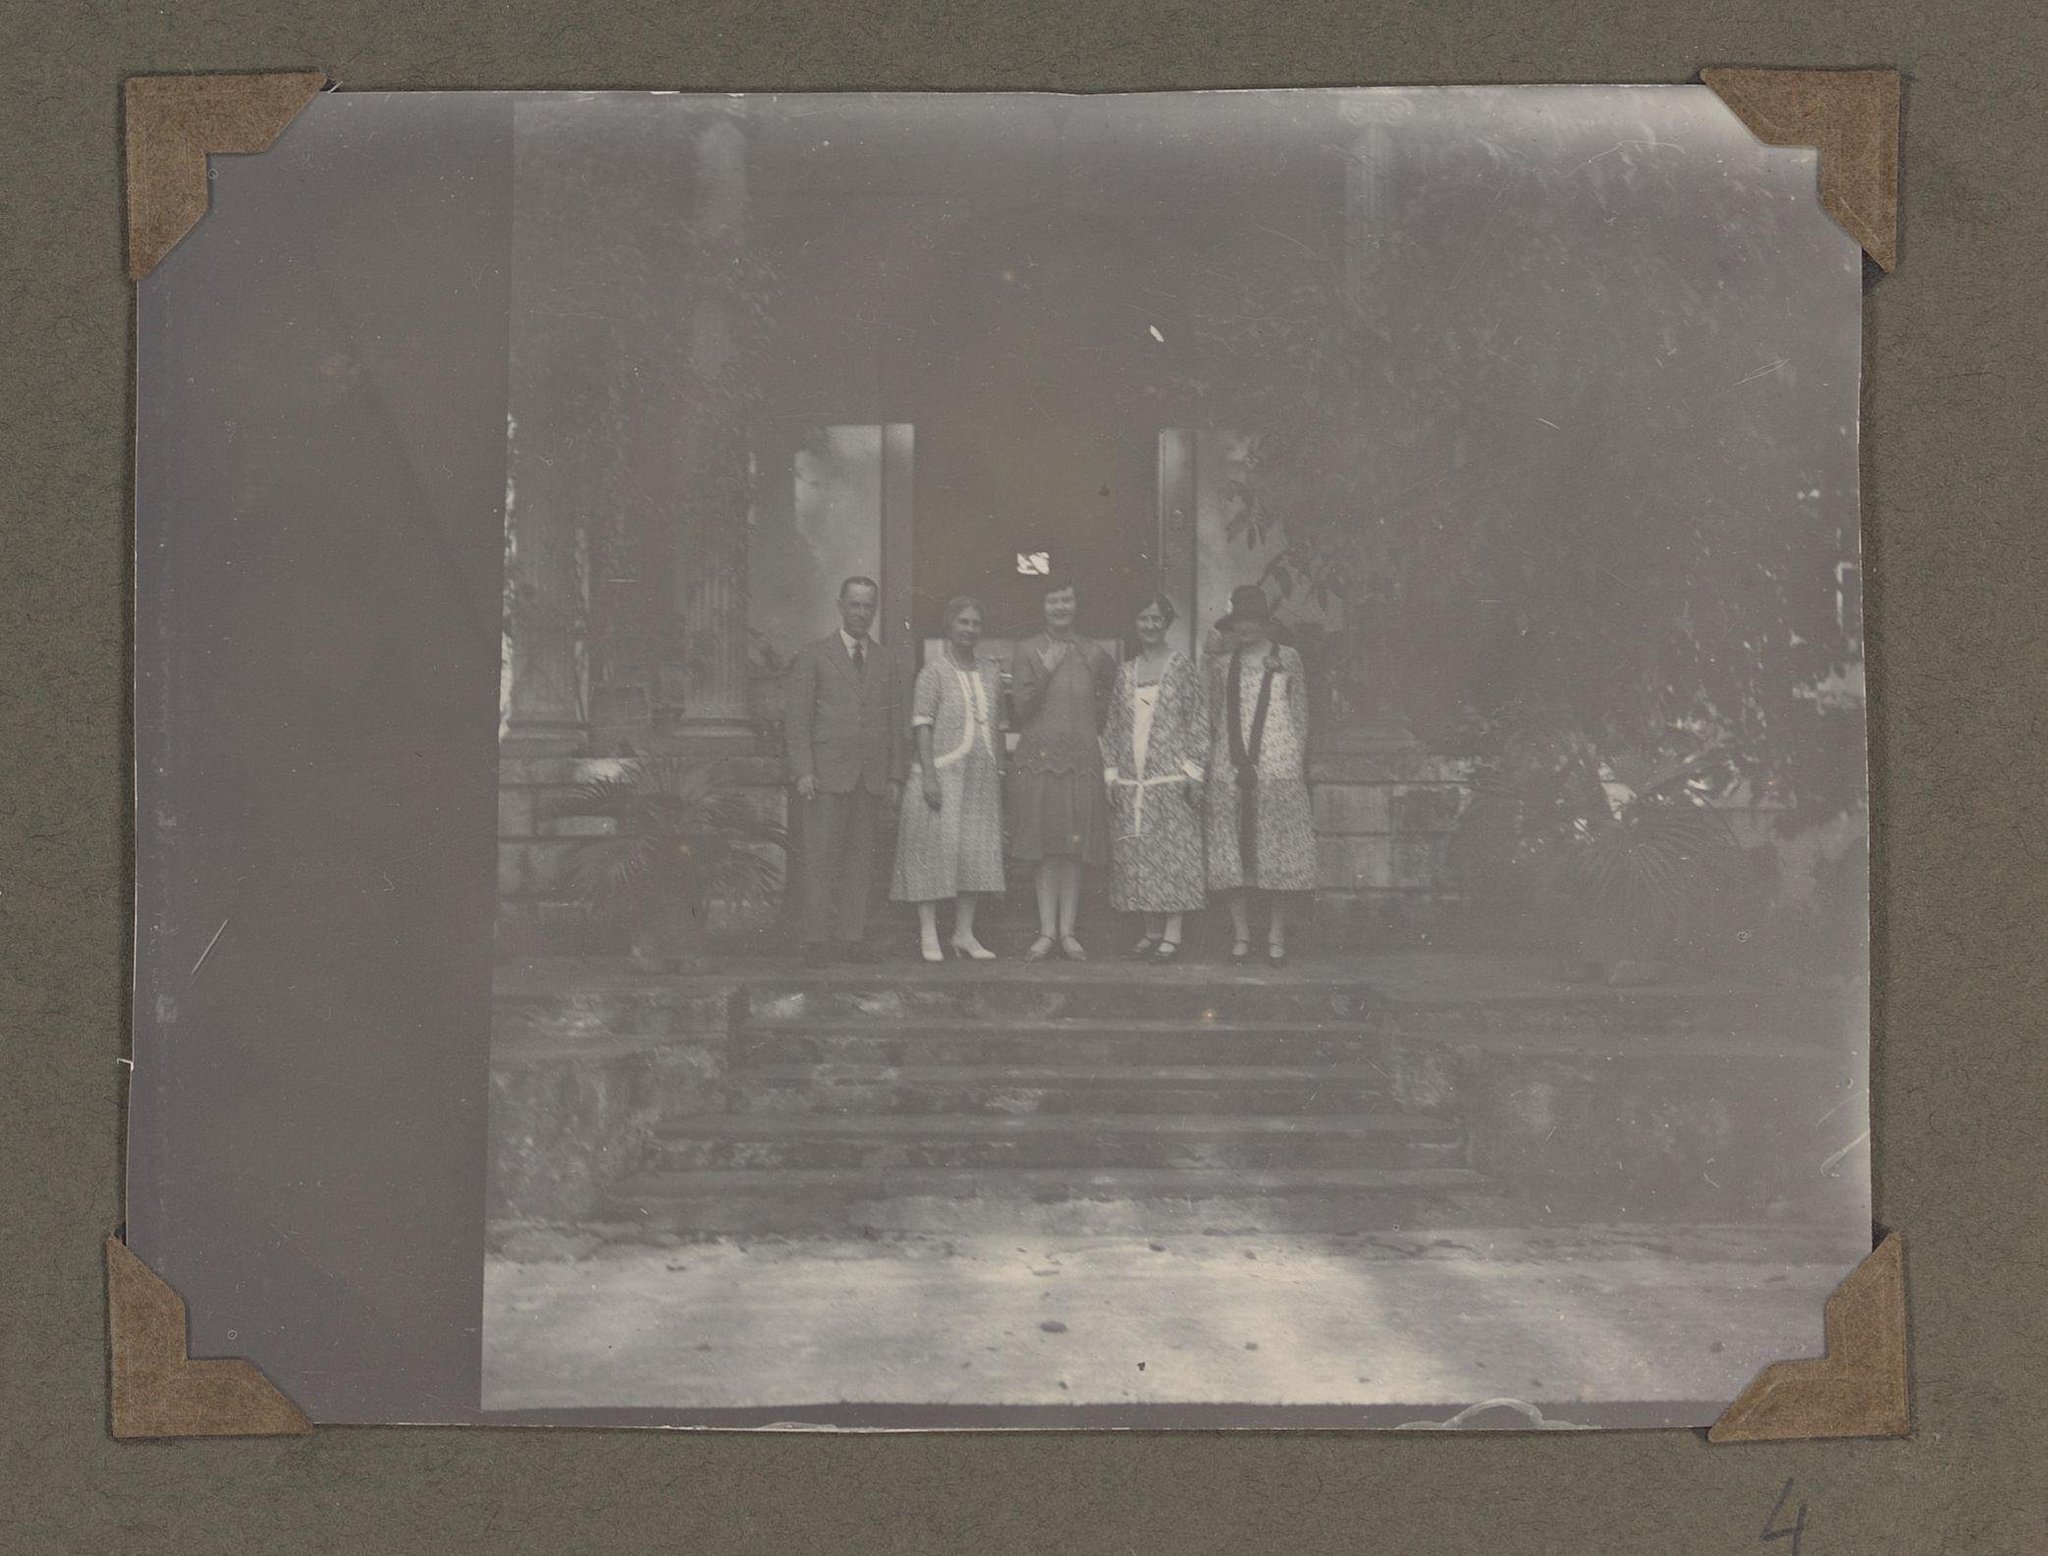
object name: photograph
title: Familiefoto van de vakantie op Barbados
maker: Anonymous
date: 1925-1927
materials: photographic support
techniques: photography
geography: suriname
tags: jetten, familie, moengo, barbados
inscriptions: inscription: ‘Barbedos’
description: Familiefoto van het gezin Jetten op vakantie in Barbados. Foto op een bladzijde van een los albumblad. Onderdeel van het ensemble met foto's van de familie van ingenieur Jetten in de mijnbouwstad Moengo in Suriname.